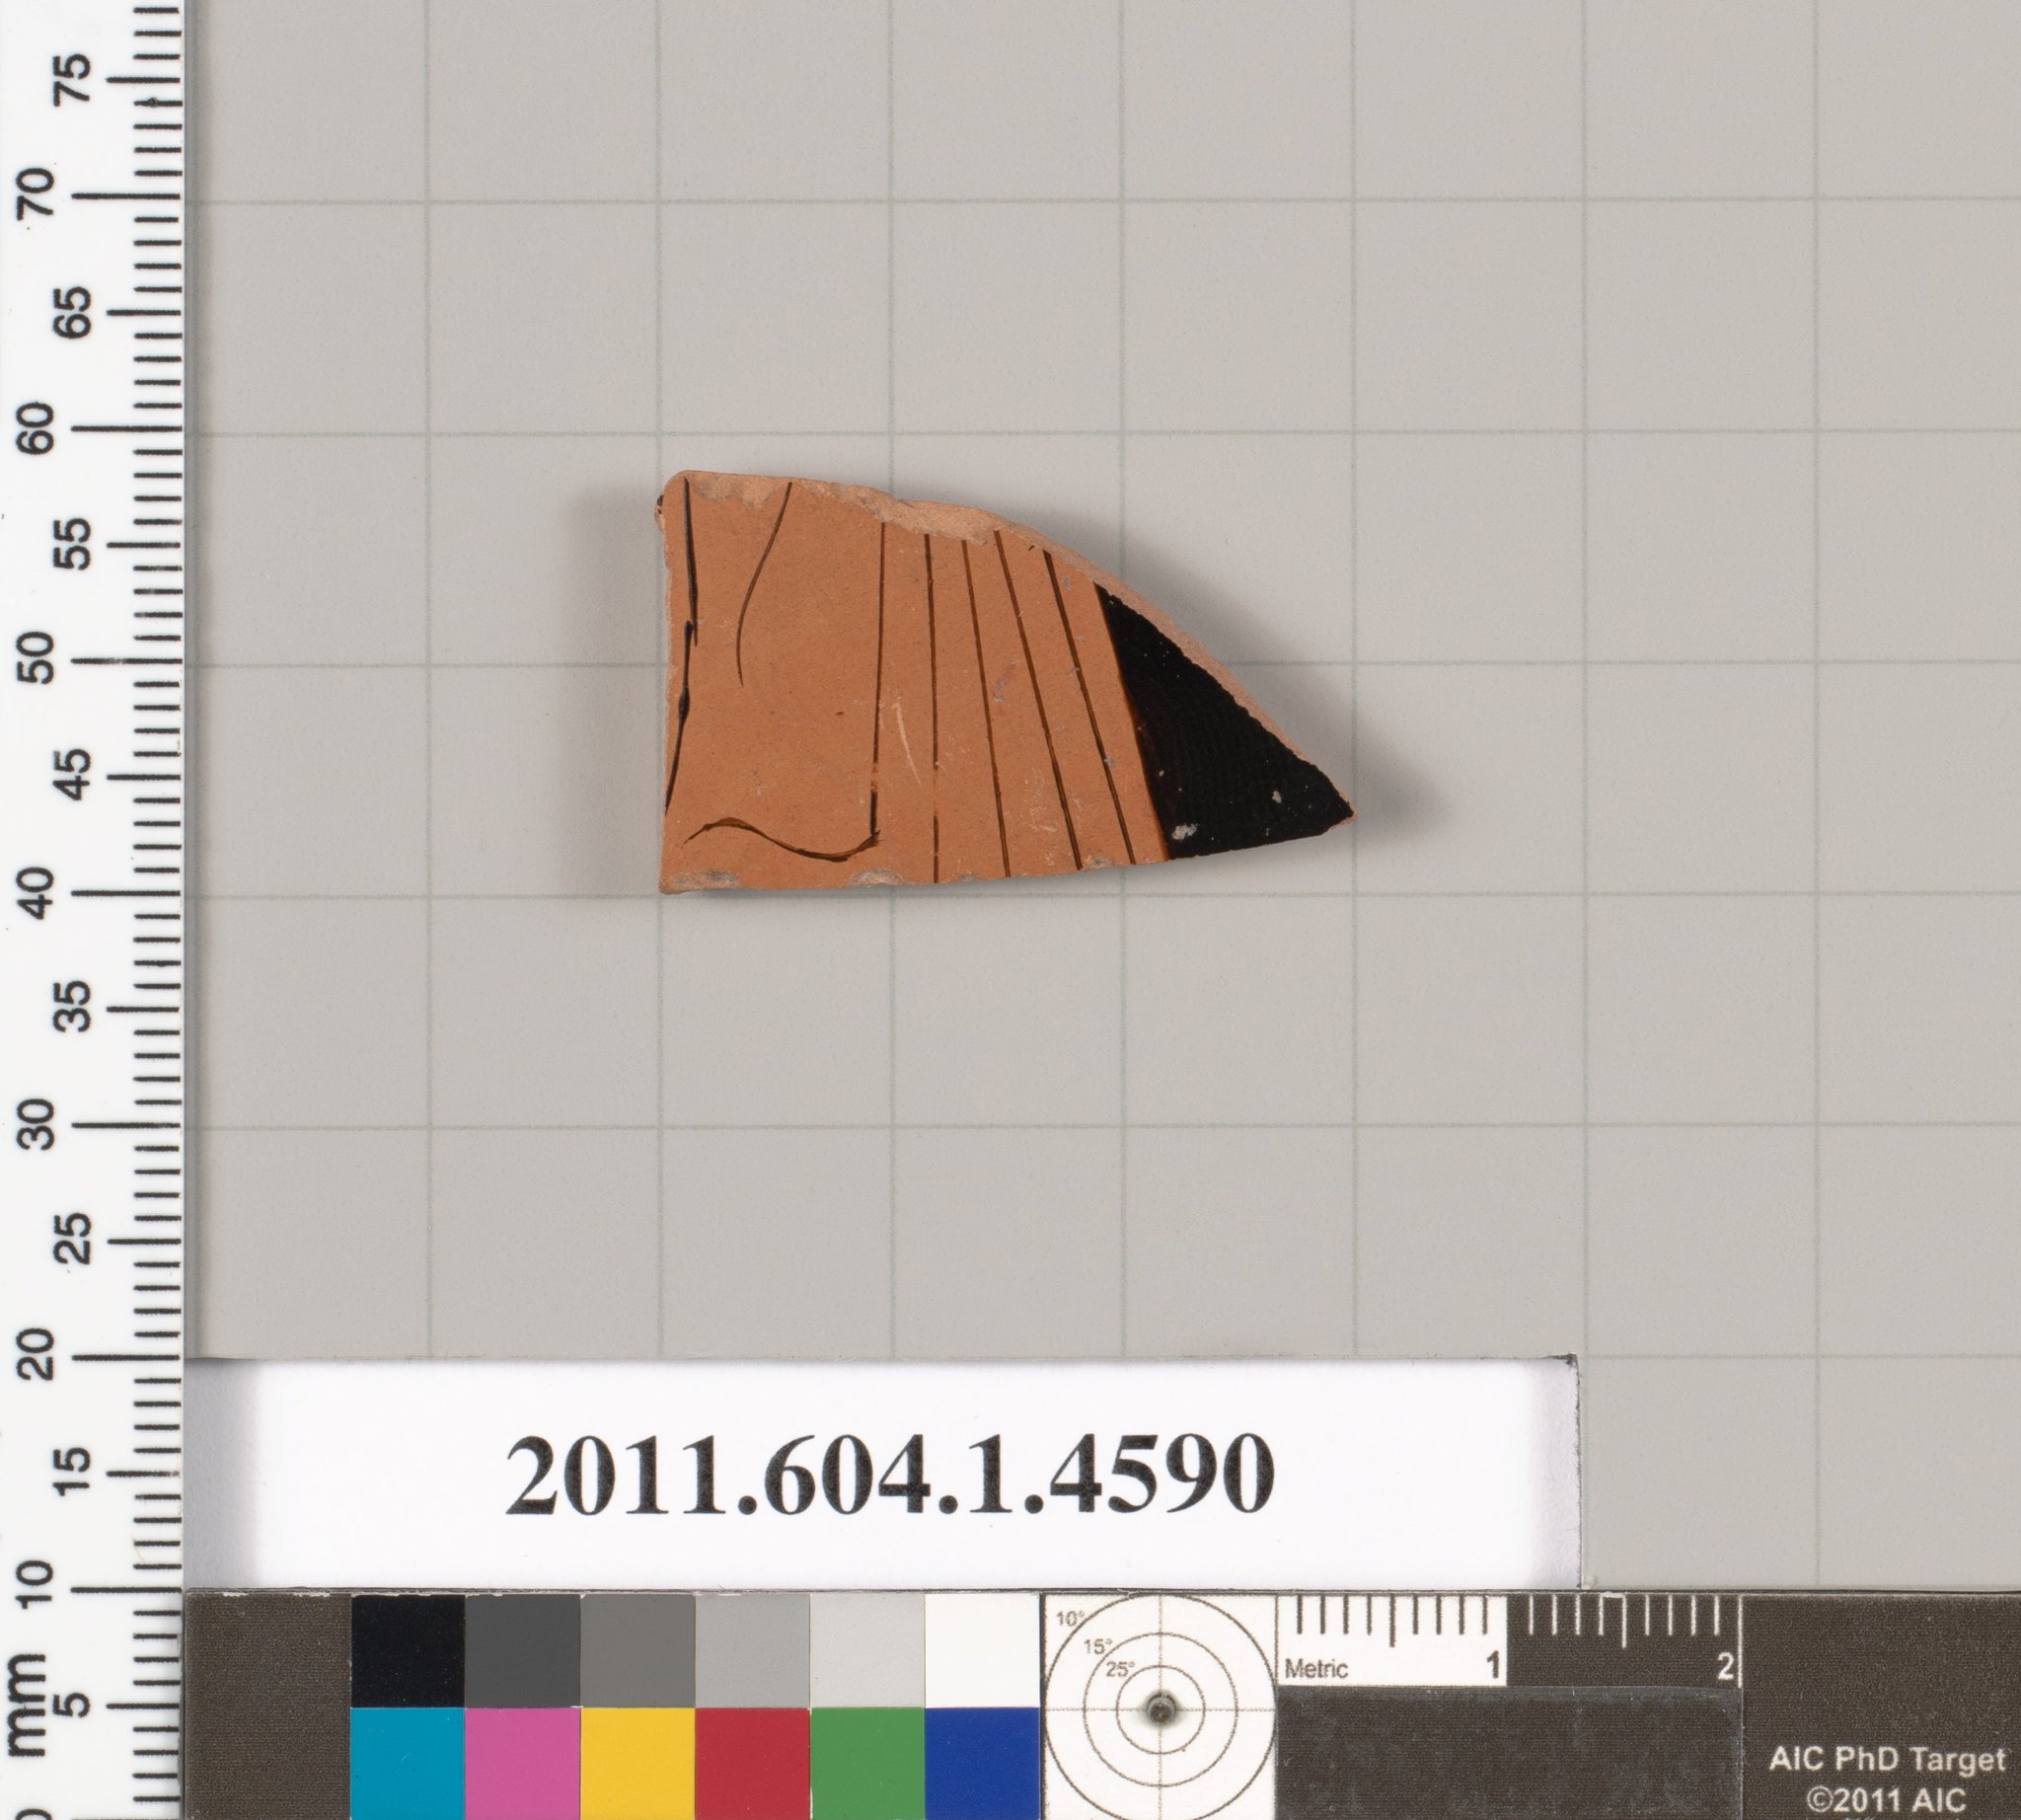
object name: kylix fragment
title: Terracotta fragment of a kylix (drinking cup)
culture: greek, attic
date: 475-451 BCE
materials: terracotta